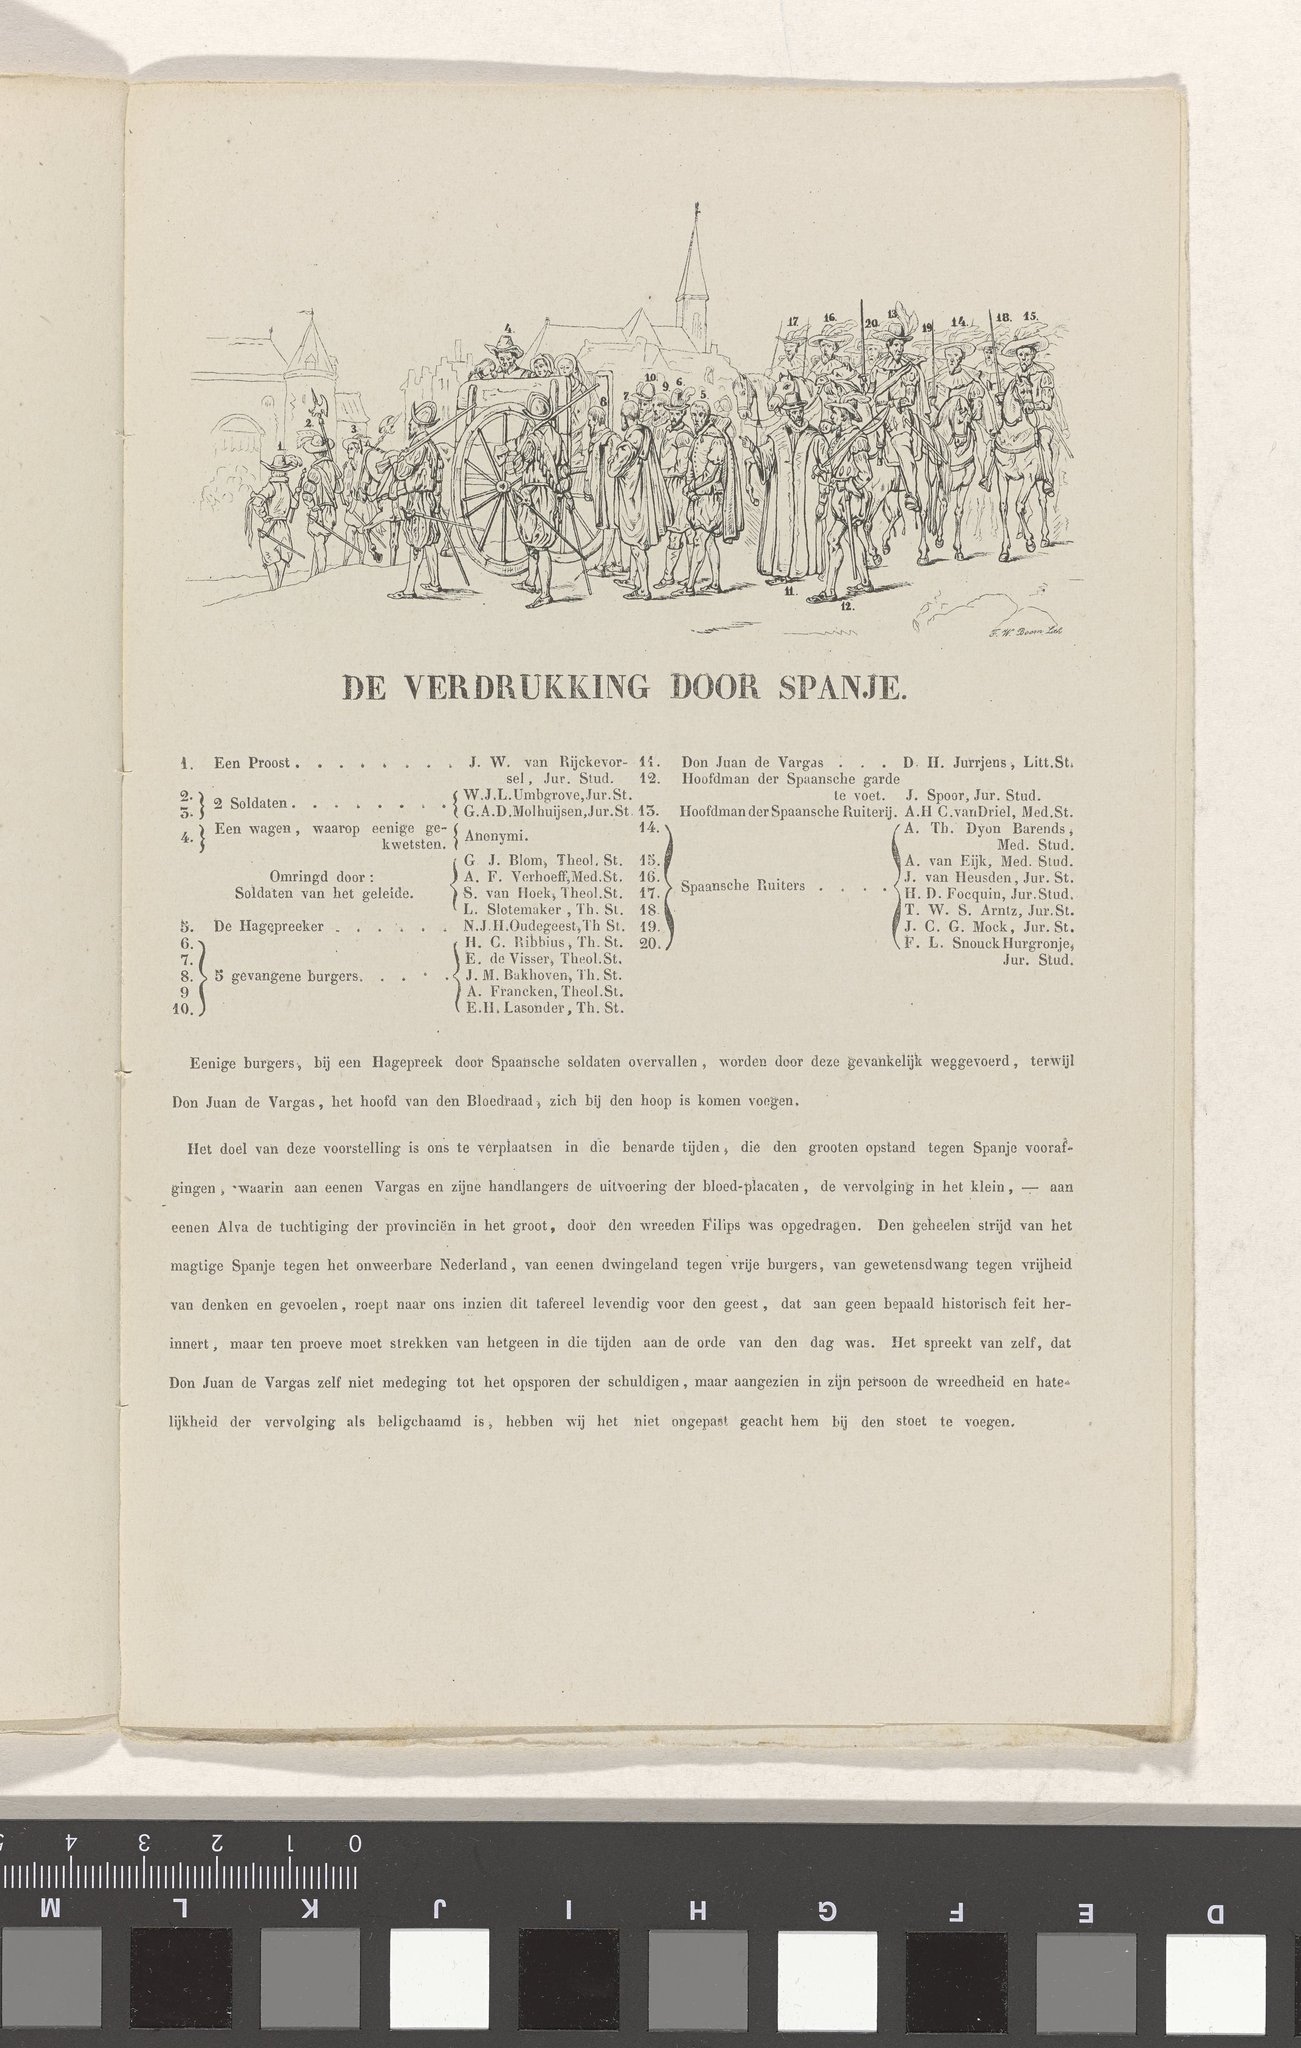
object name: print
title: De Verdrukking door Spanje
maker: f.w. boom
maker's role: print maker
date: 1851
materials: paper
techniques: letterpress printing, lithograph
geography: utrecht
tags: students' pageant, costumes used in pageants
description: Episode uit het begin van de Tachtigjarige Oorlog, 1567. Met legenda 1-20 met de namen van de studenten en daaronder een tekst over de voorgestelde gebeurtenis. Onderdeel van het boekje met acht verkleinde voorstellingen van de acht prenten in de serie van de maskerade van de Utrechtse studenten, 25 juni 1851. De maskerade verbeeldt in taferelen acht episodes uit de vaderlandse geschiedenis.